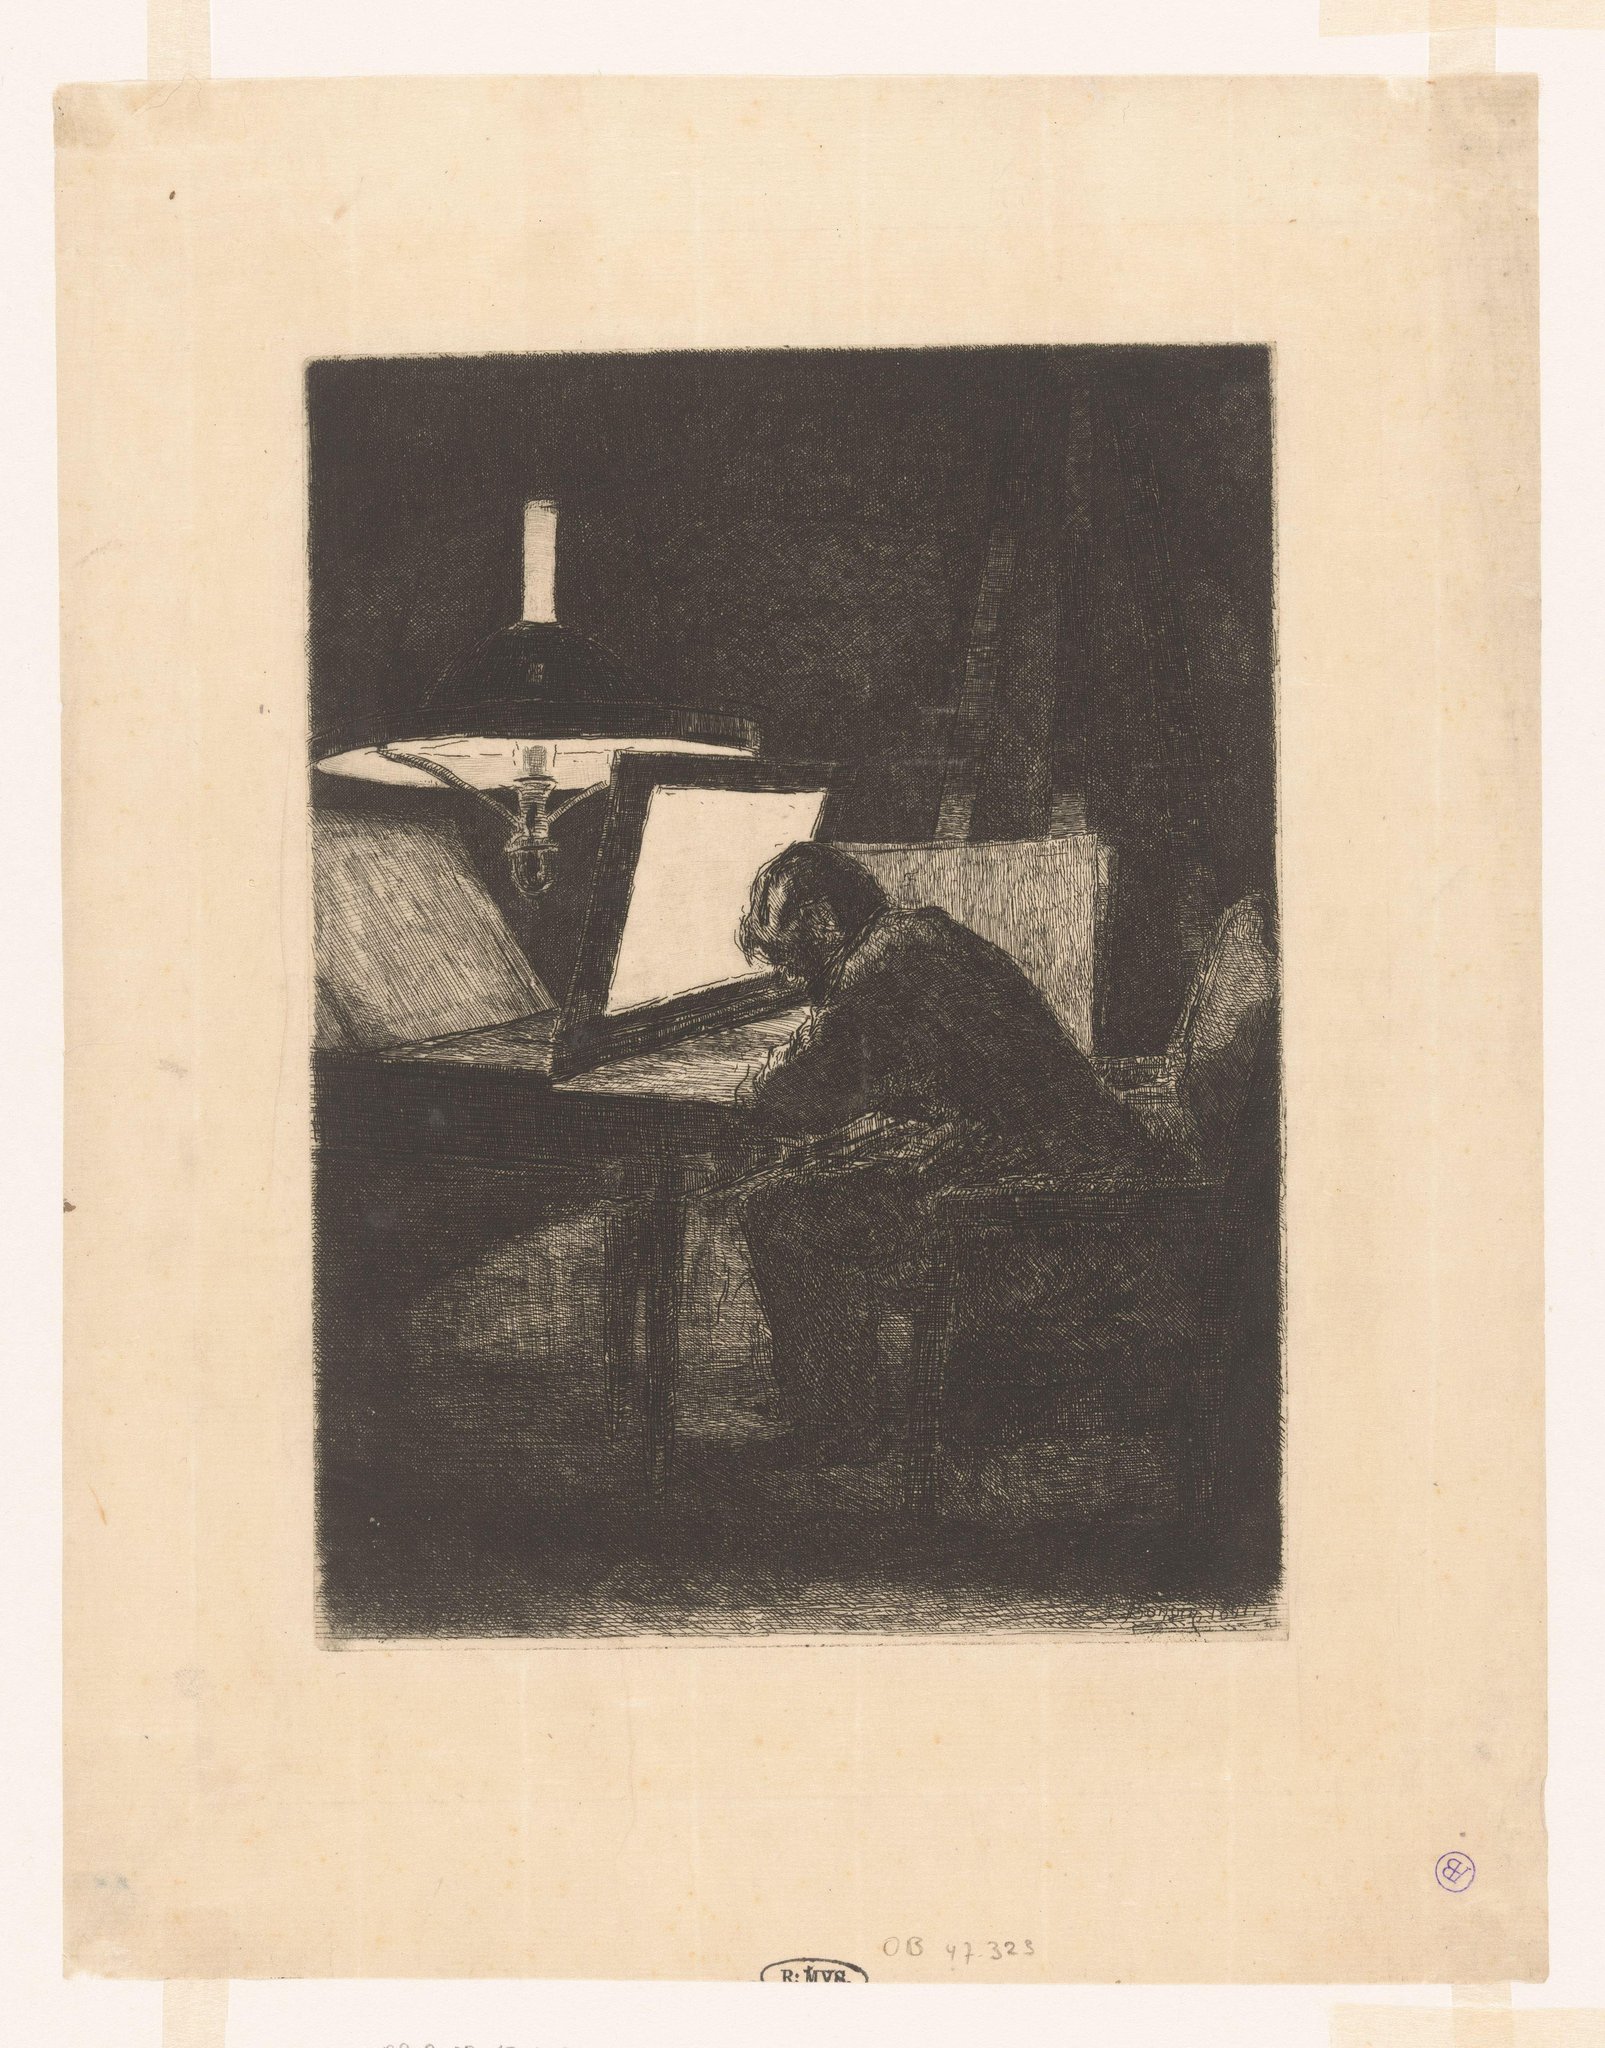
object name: print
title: Etser bij lamplicht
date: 1874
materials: paper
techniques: etching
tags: engraver, etcher, artist at work, in his workshop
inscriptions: collector's mark: Lugt 76, collector's mark: Lugt 2228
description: Maakt deel uit van een zesdelige serie, getiteld: Six Eaux-fortes, dessinées et gravées par F. Bonvin, Peintre. De eerste staat werd in 1861 door Bonvin uitgegeven in Parijs.